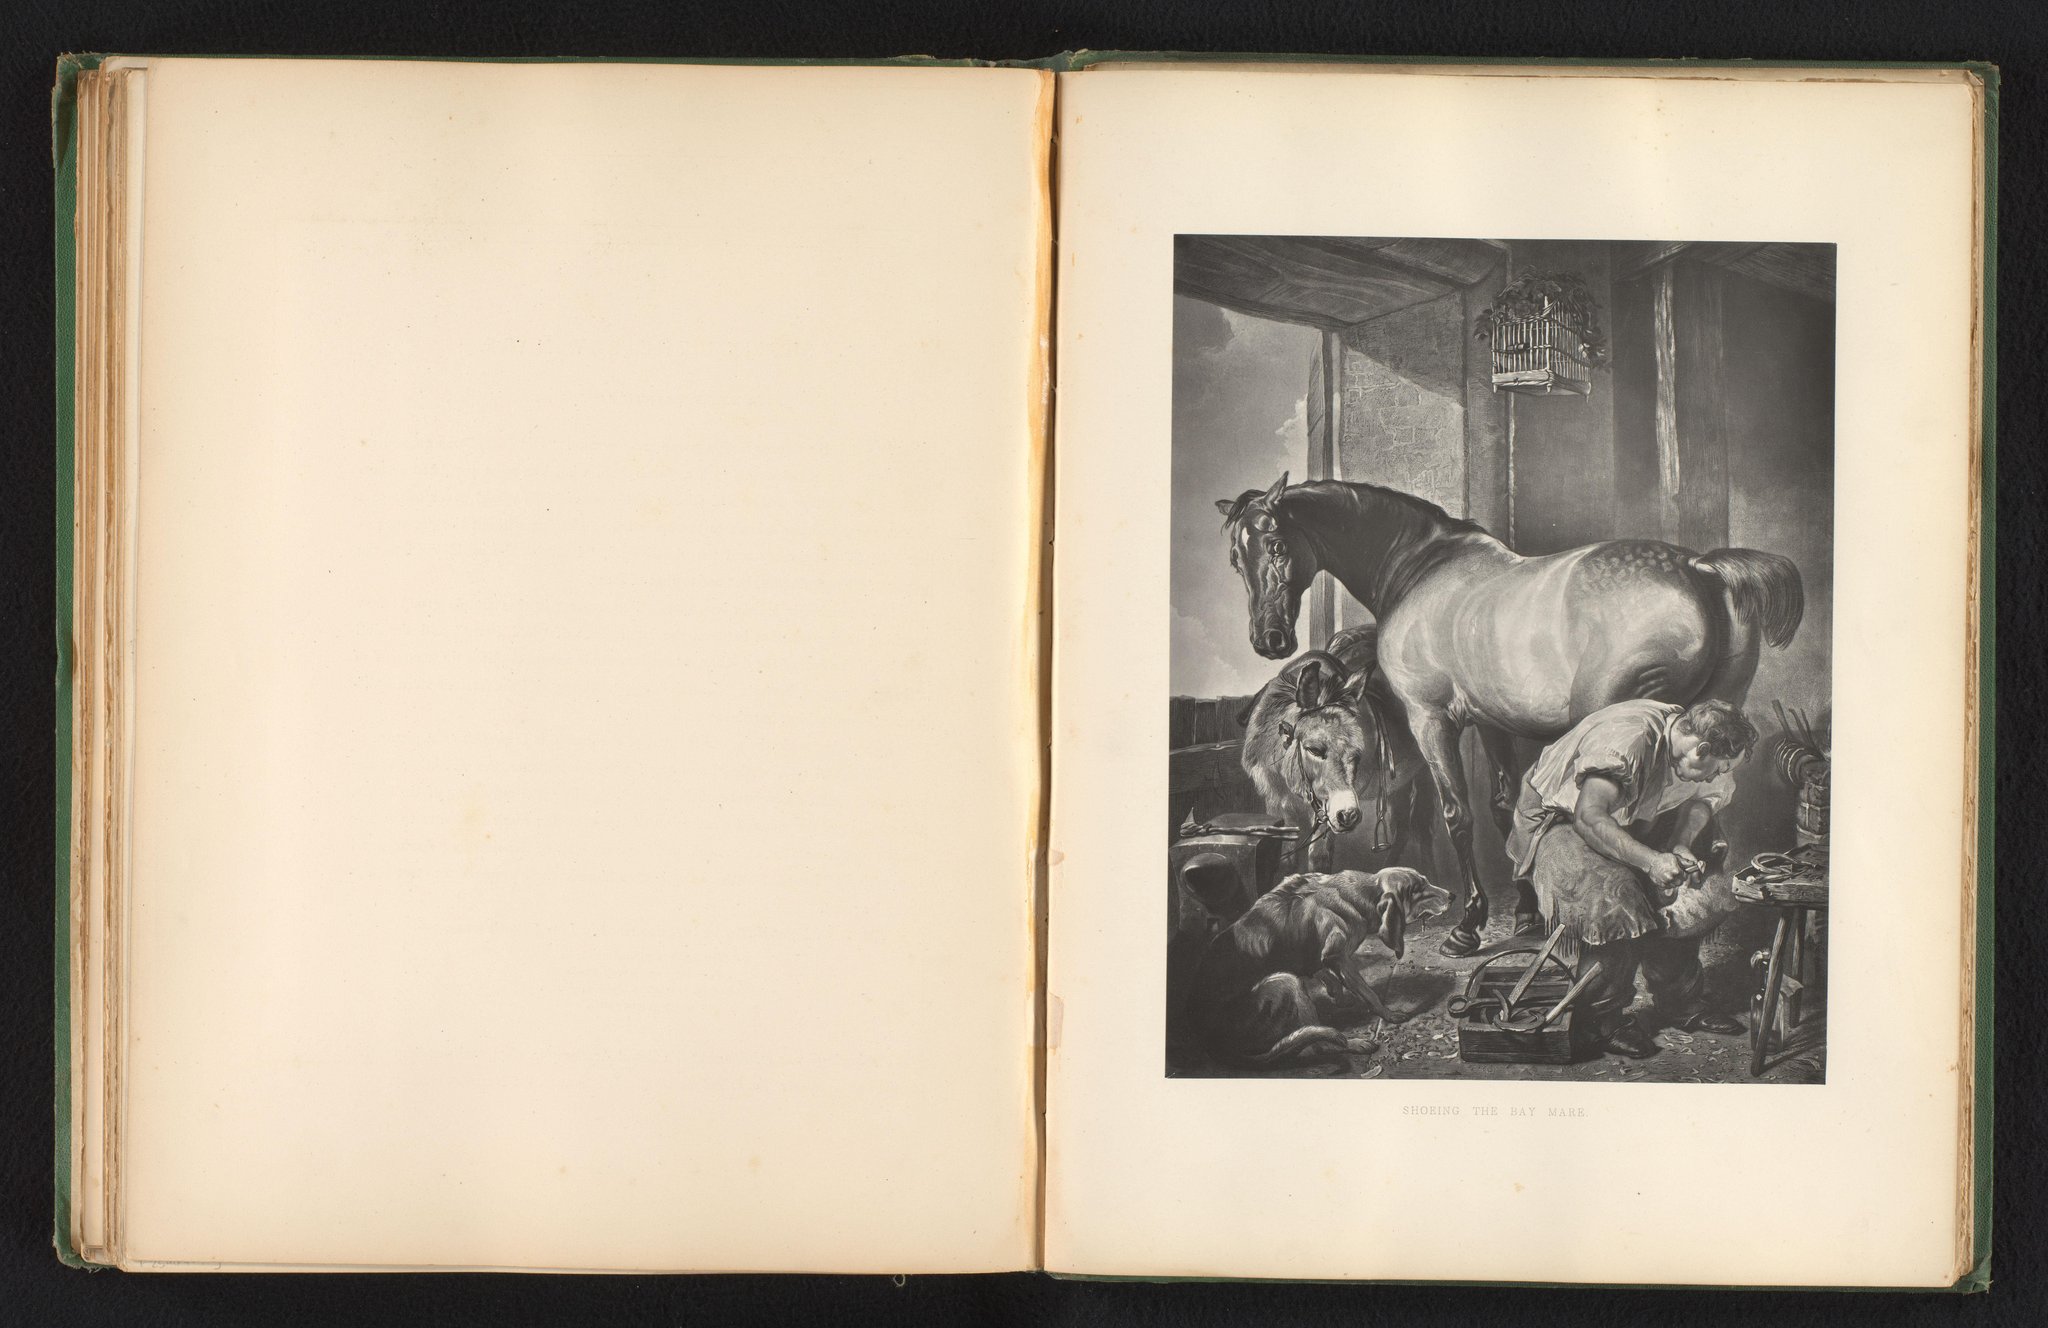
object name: page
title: Shoeing the bay mare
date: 1878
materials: paper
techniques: woodburytype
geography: london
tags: horse, smith, blacksmith, horseshoe